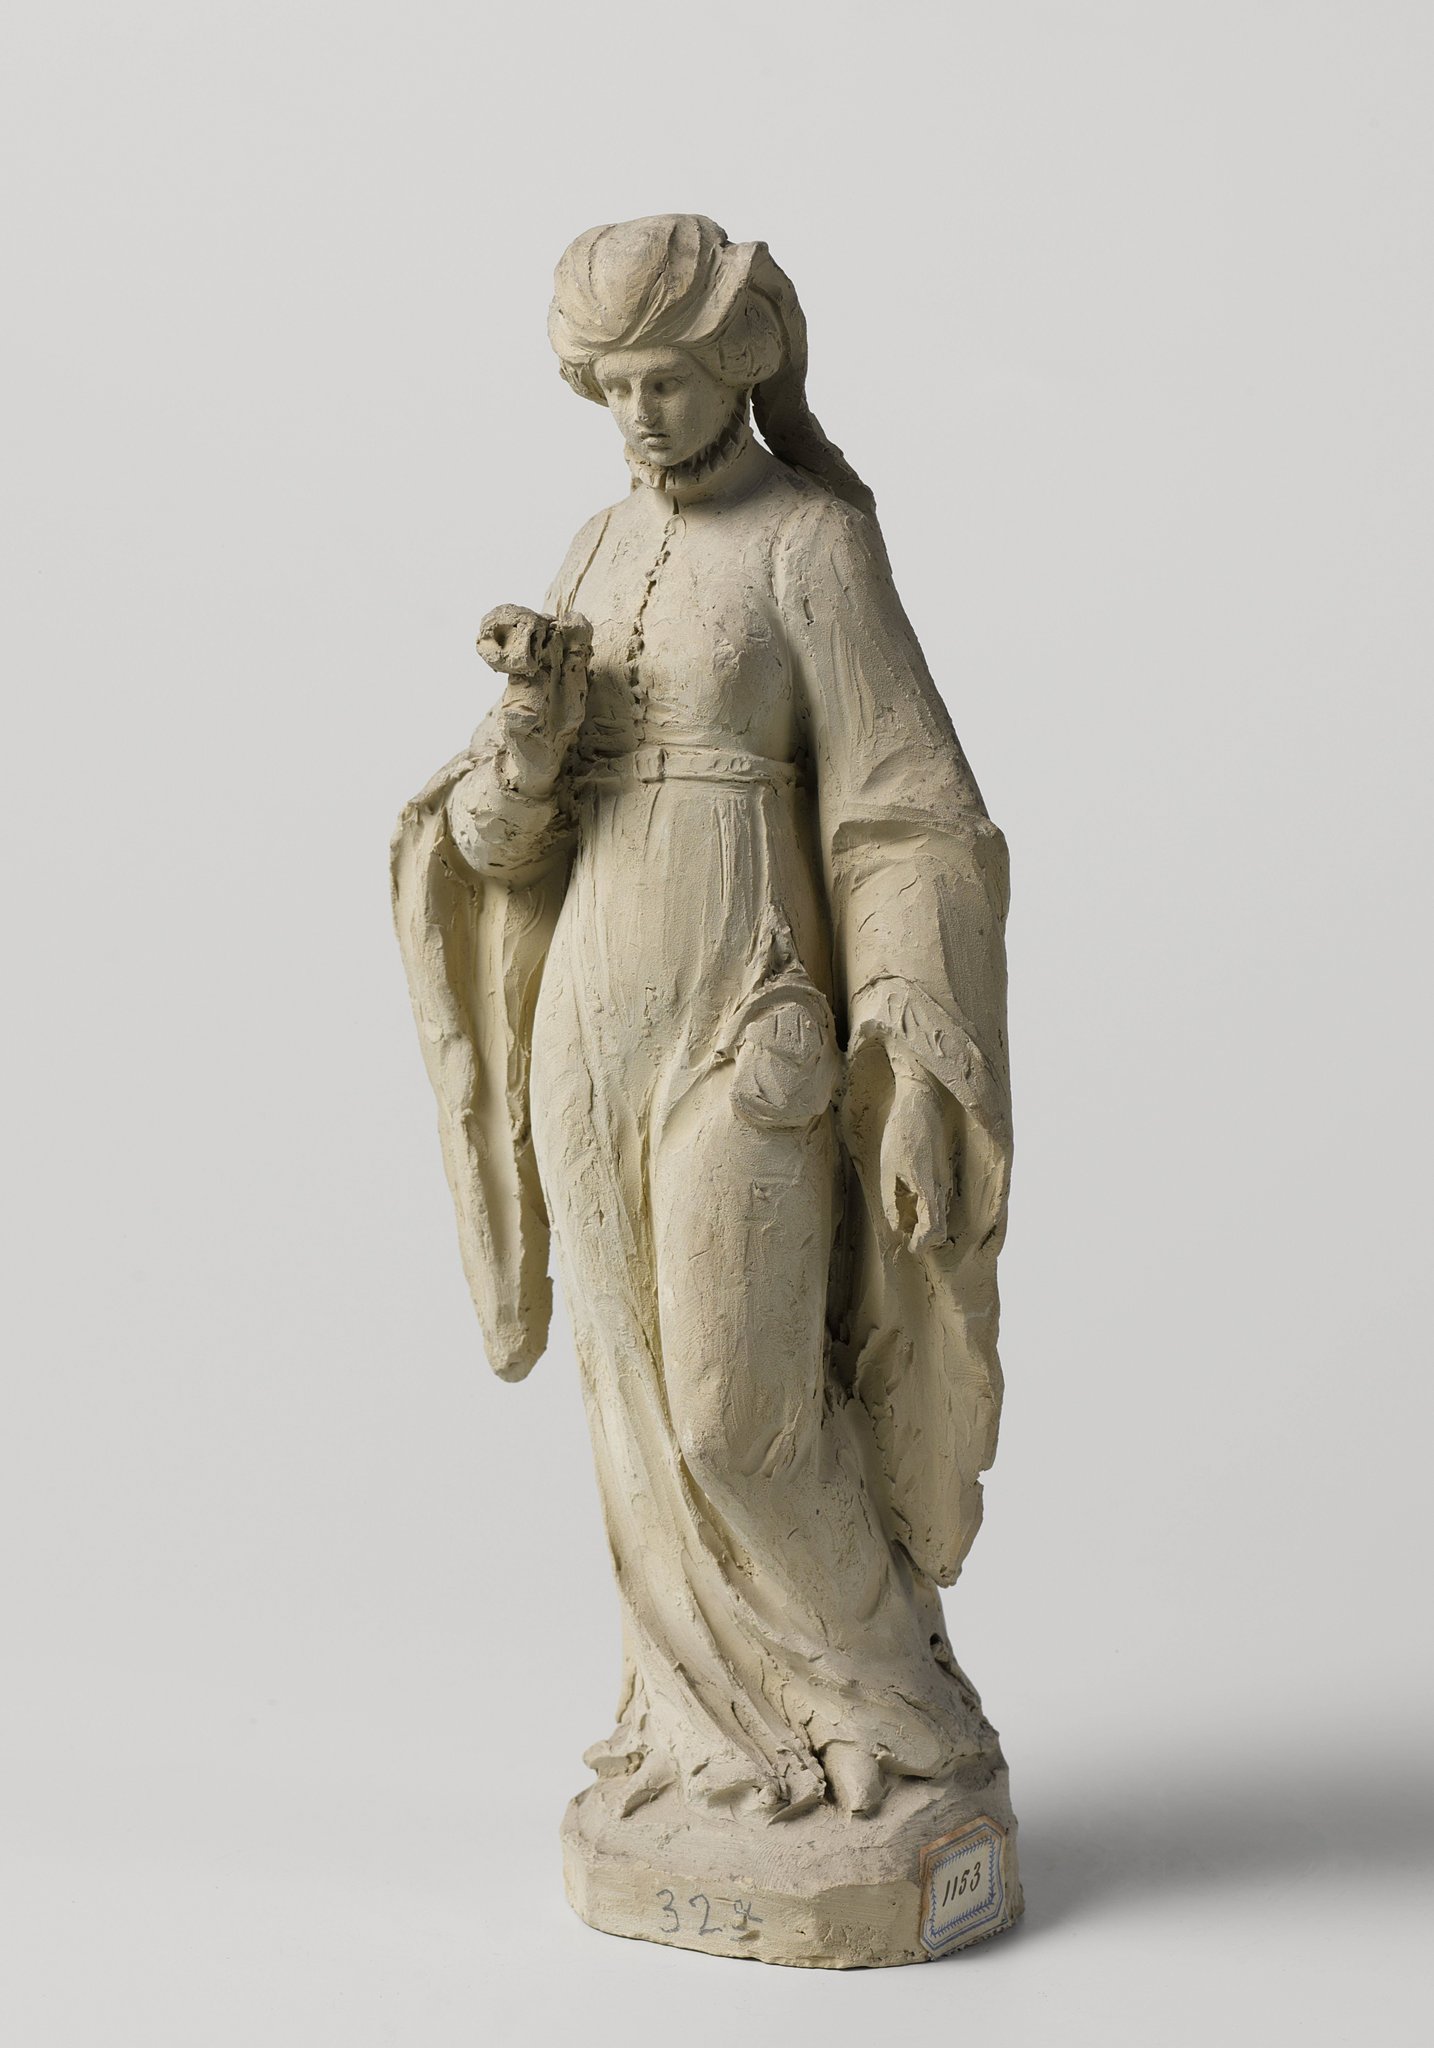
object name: sculpture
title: Edelvrouw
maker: eugène lacomblé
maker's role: draughtsman, painter, sculptor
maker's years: 1828-1905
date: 1800-1900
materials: clay